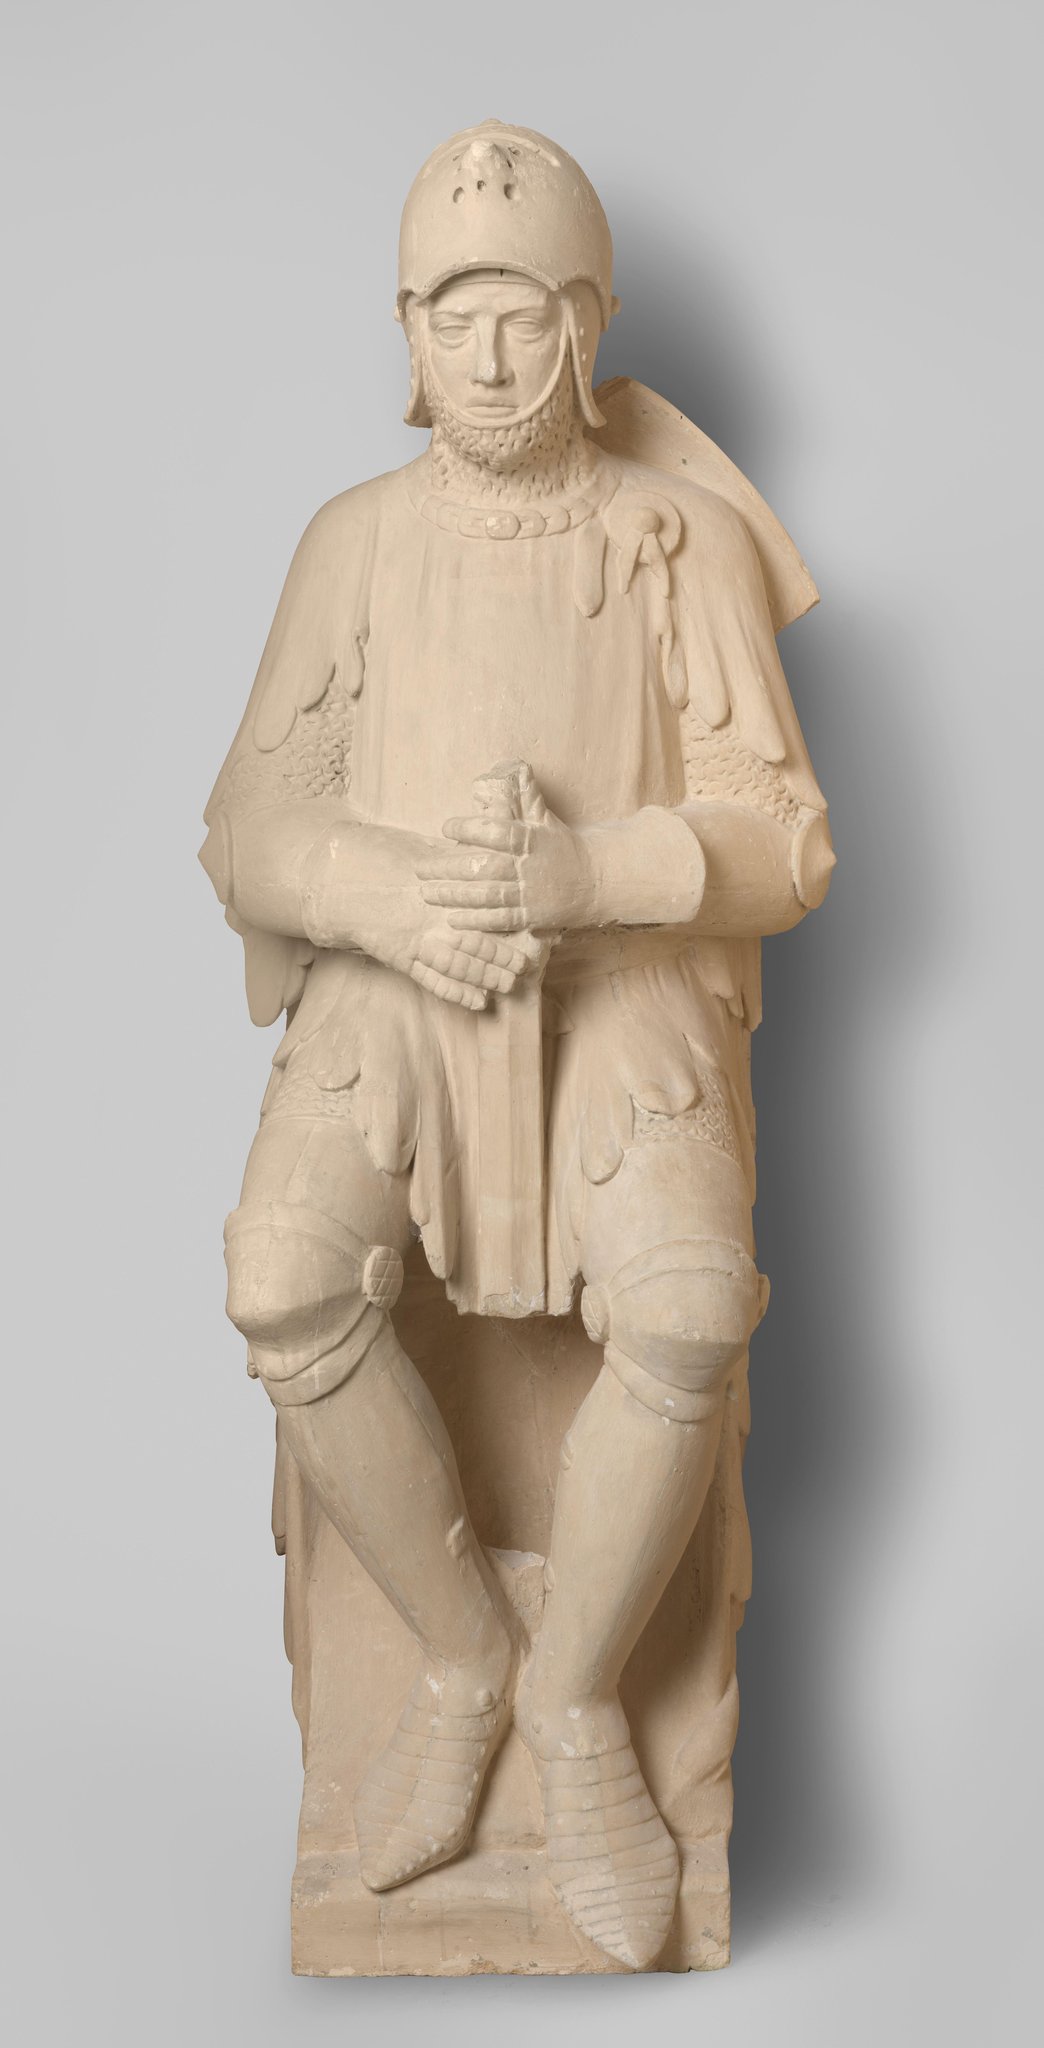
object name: sculpture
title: Man (ridder) ten voeten uit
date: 1500-1900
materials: stone